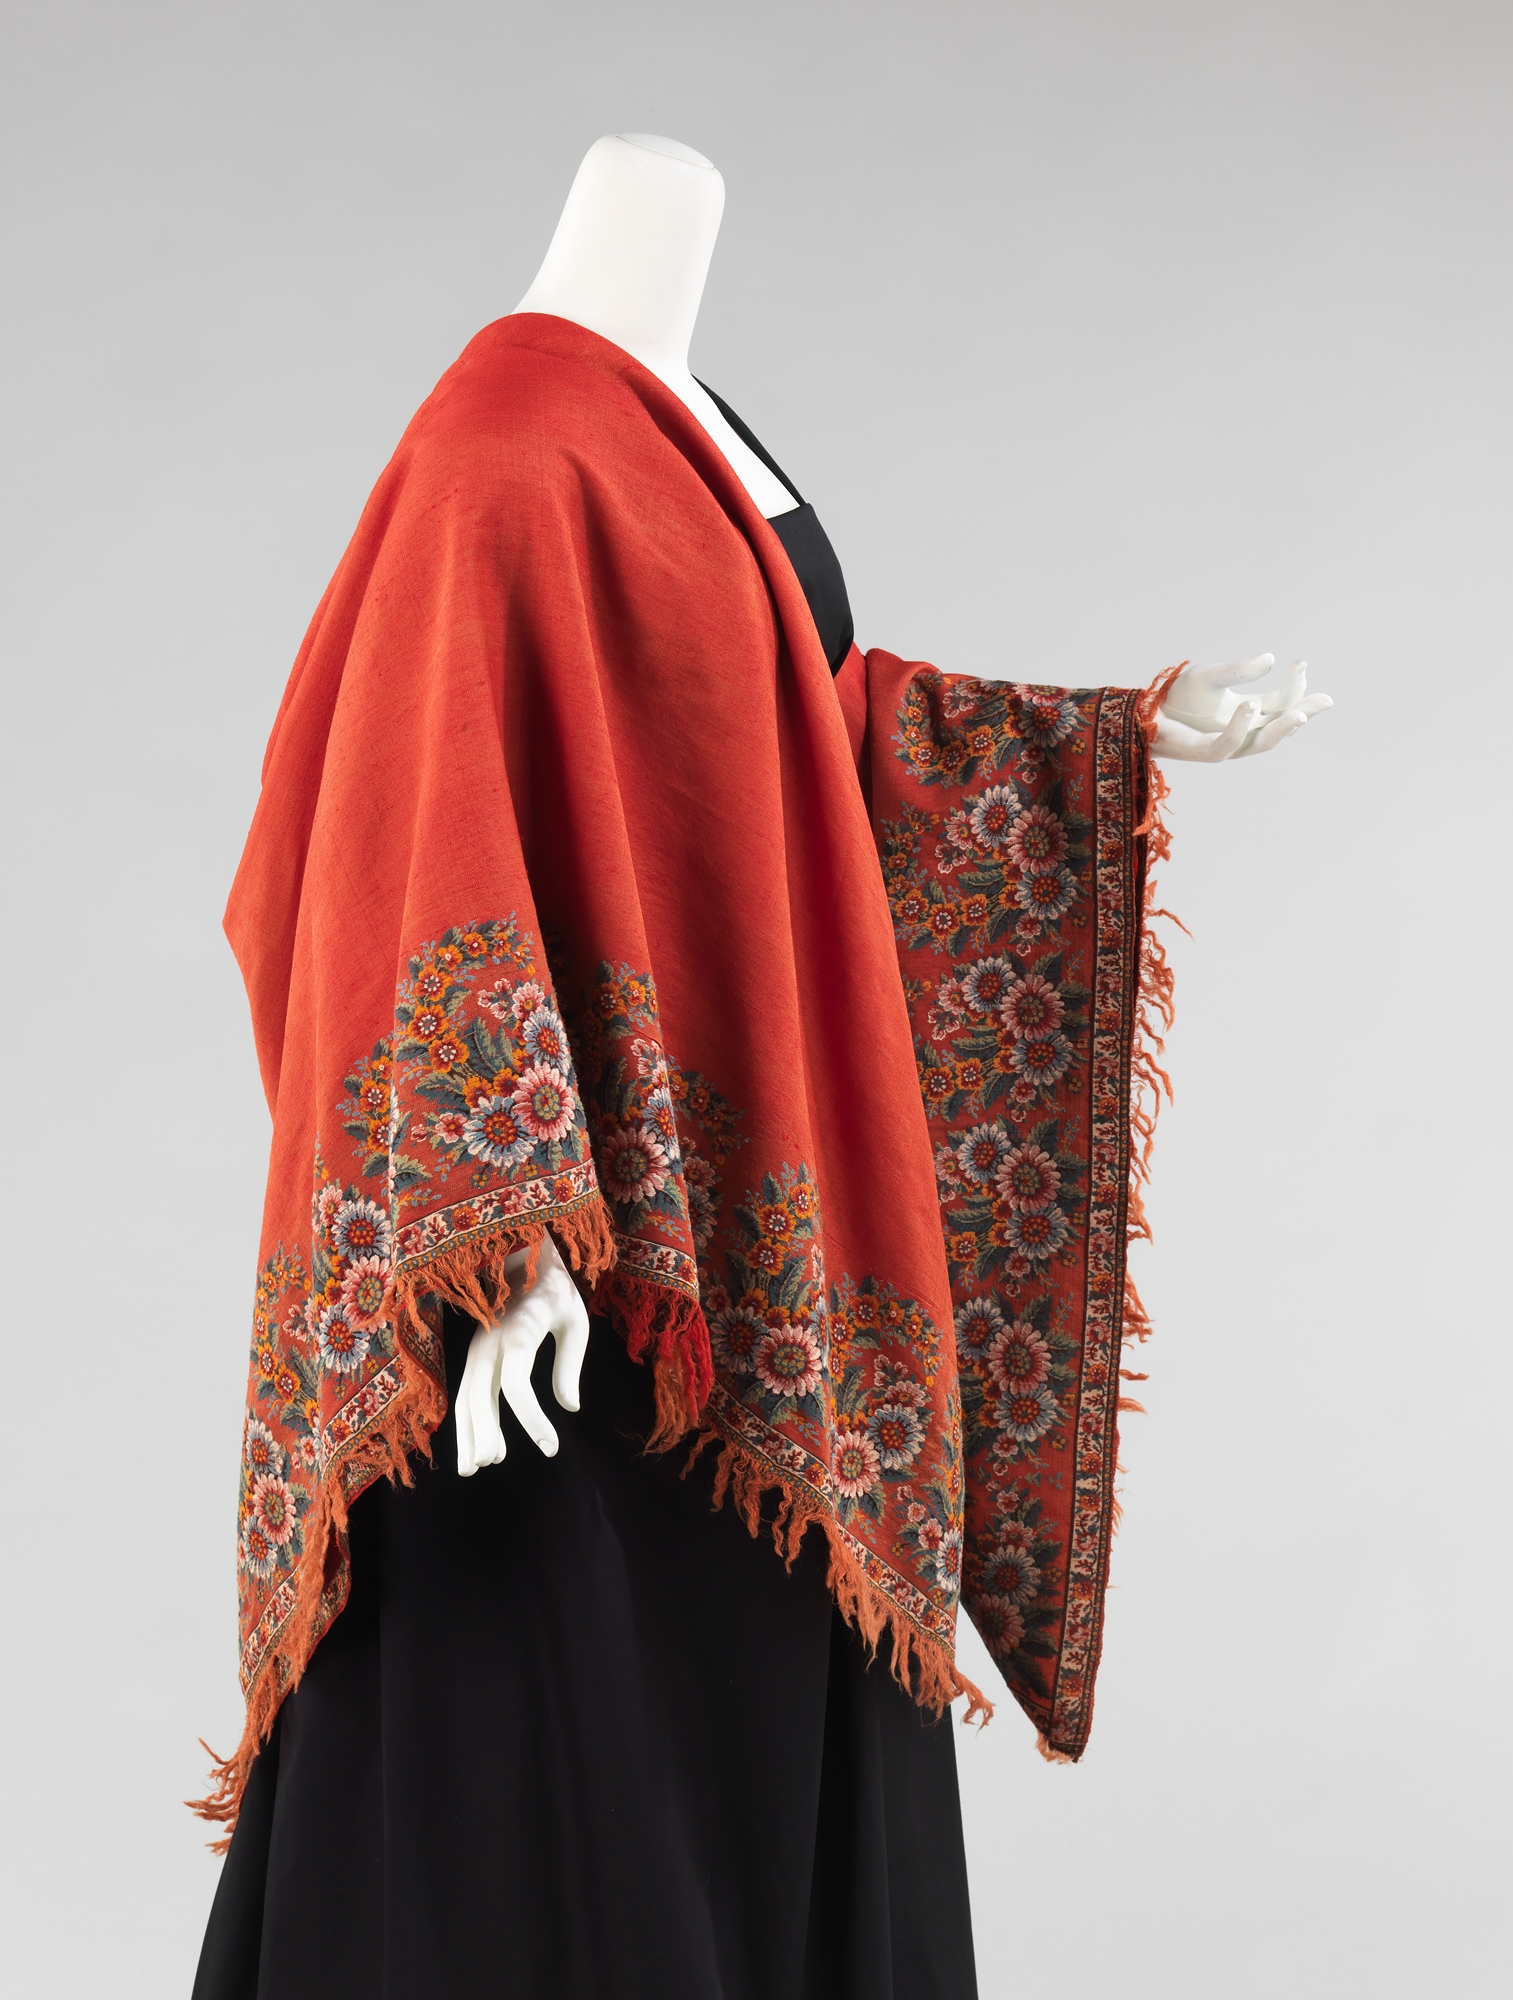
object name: shawl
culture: french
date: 1801-1825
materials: wool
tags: flowers